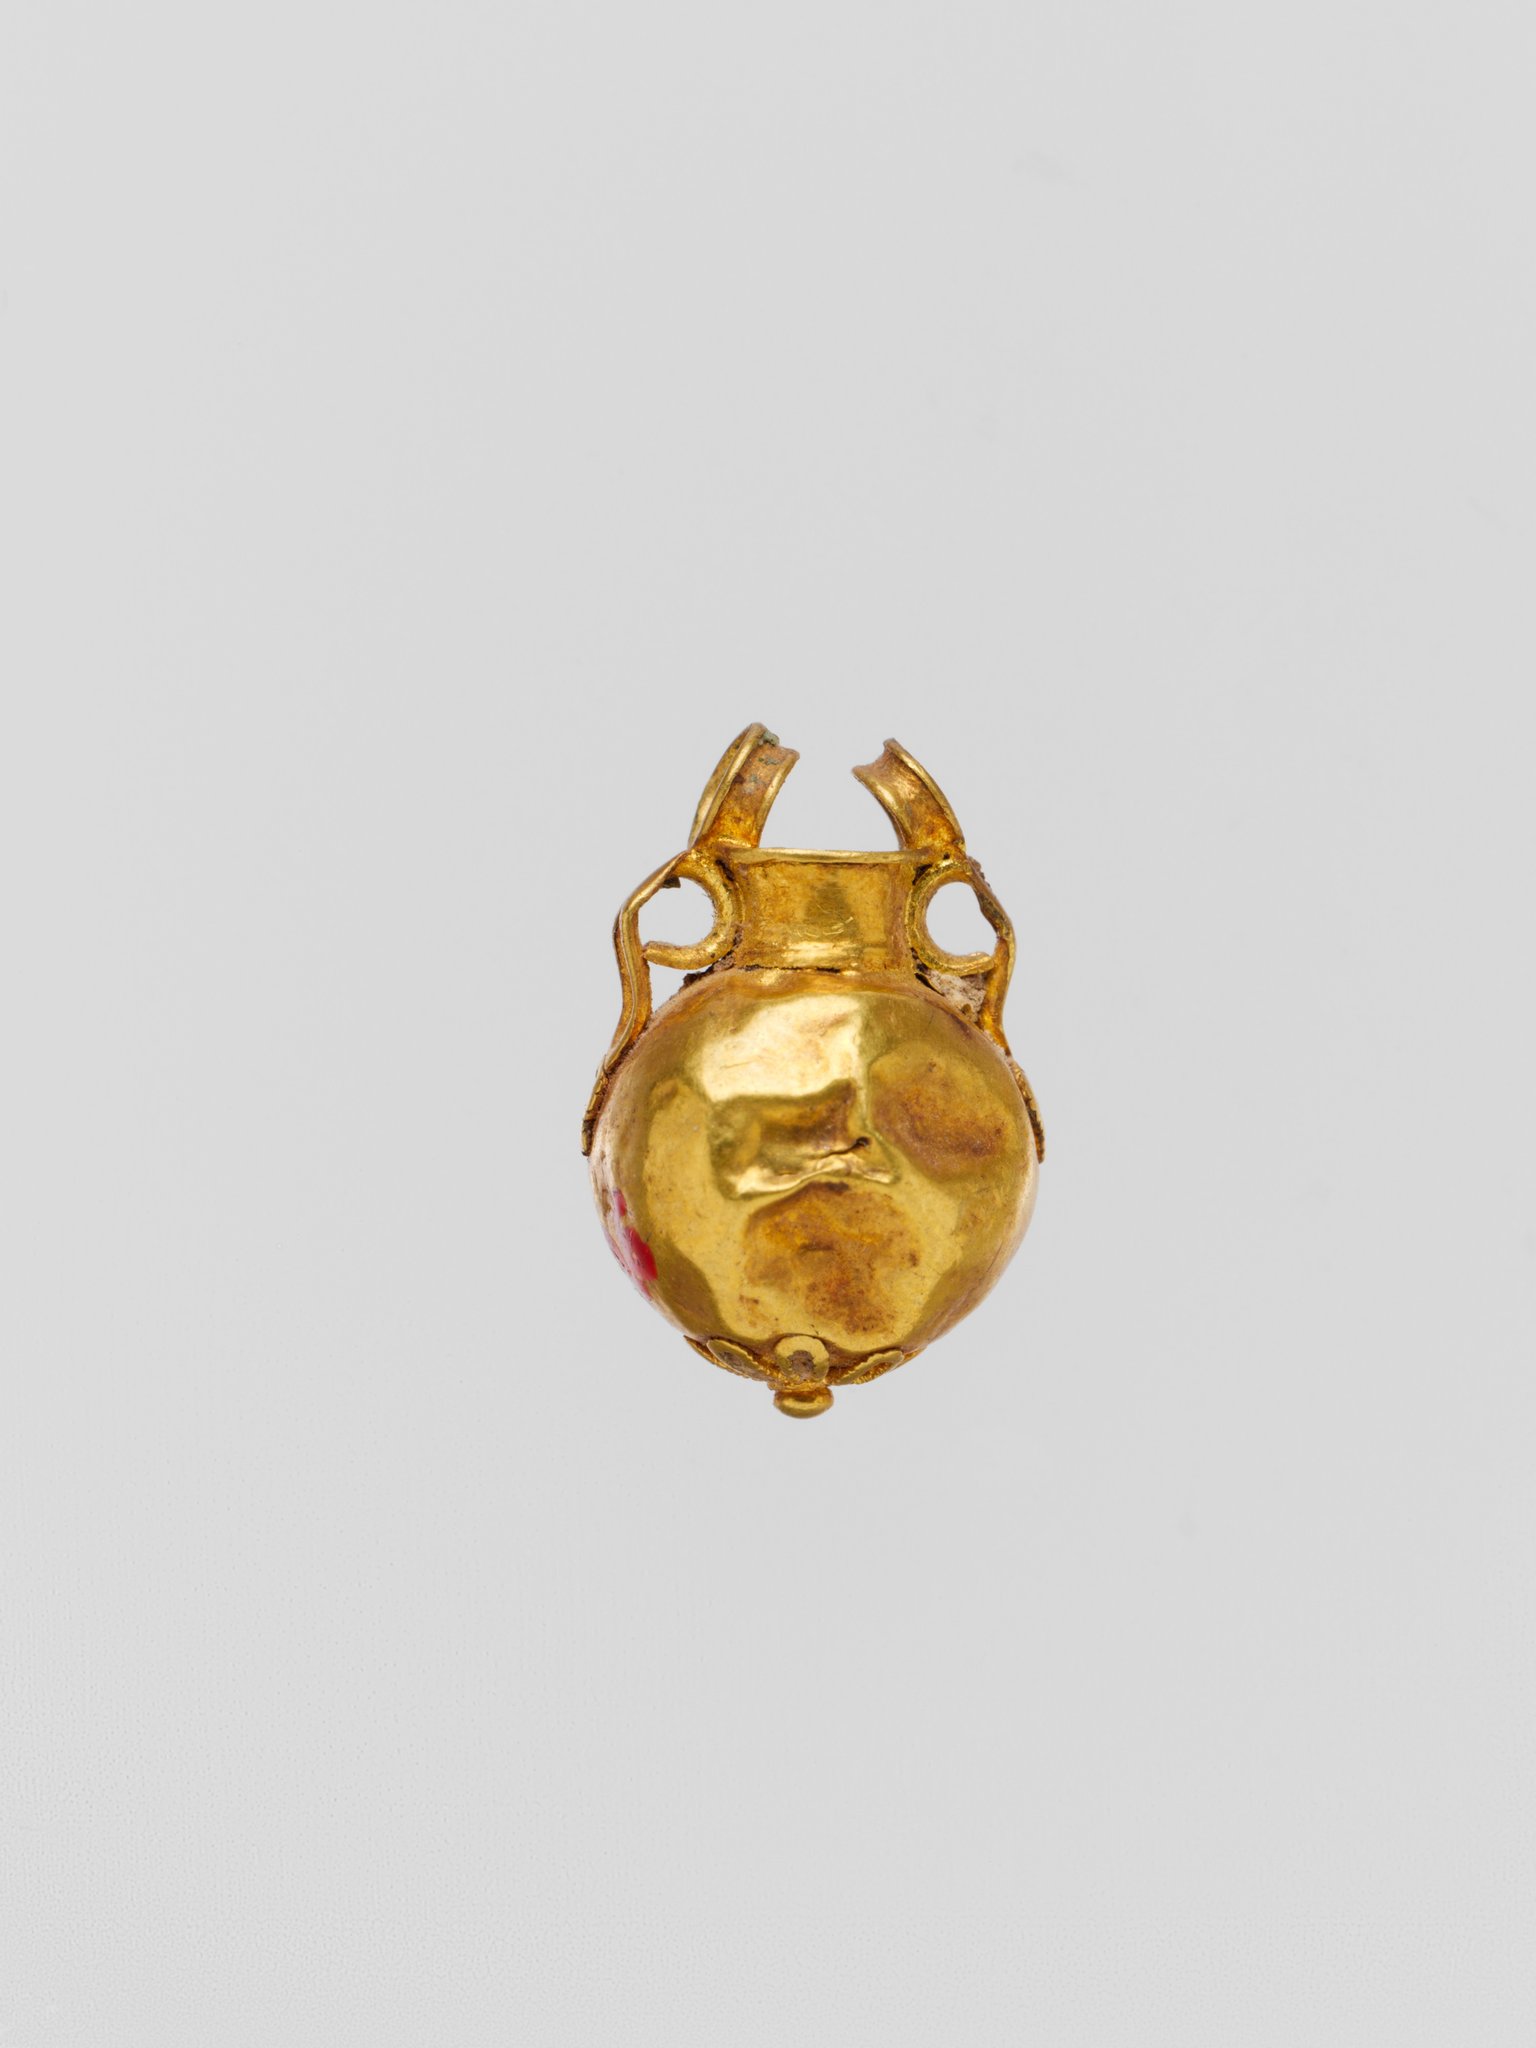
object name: pendant in the form of a vase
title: Gold pendant in the form of a vase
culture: cypriot or greek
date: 534-401 BCE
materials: gold